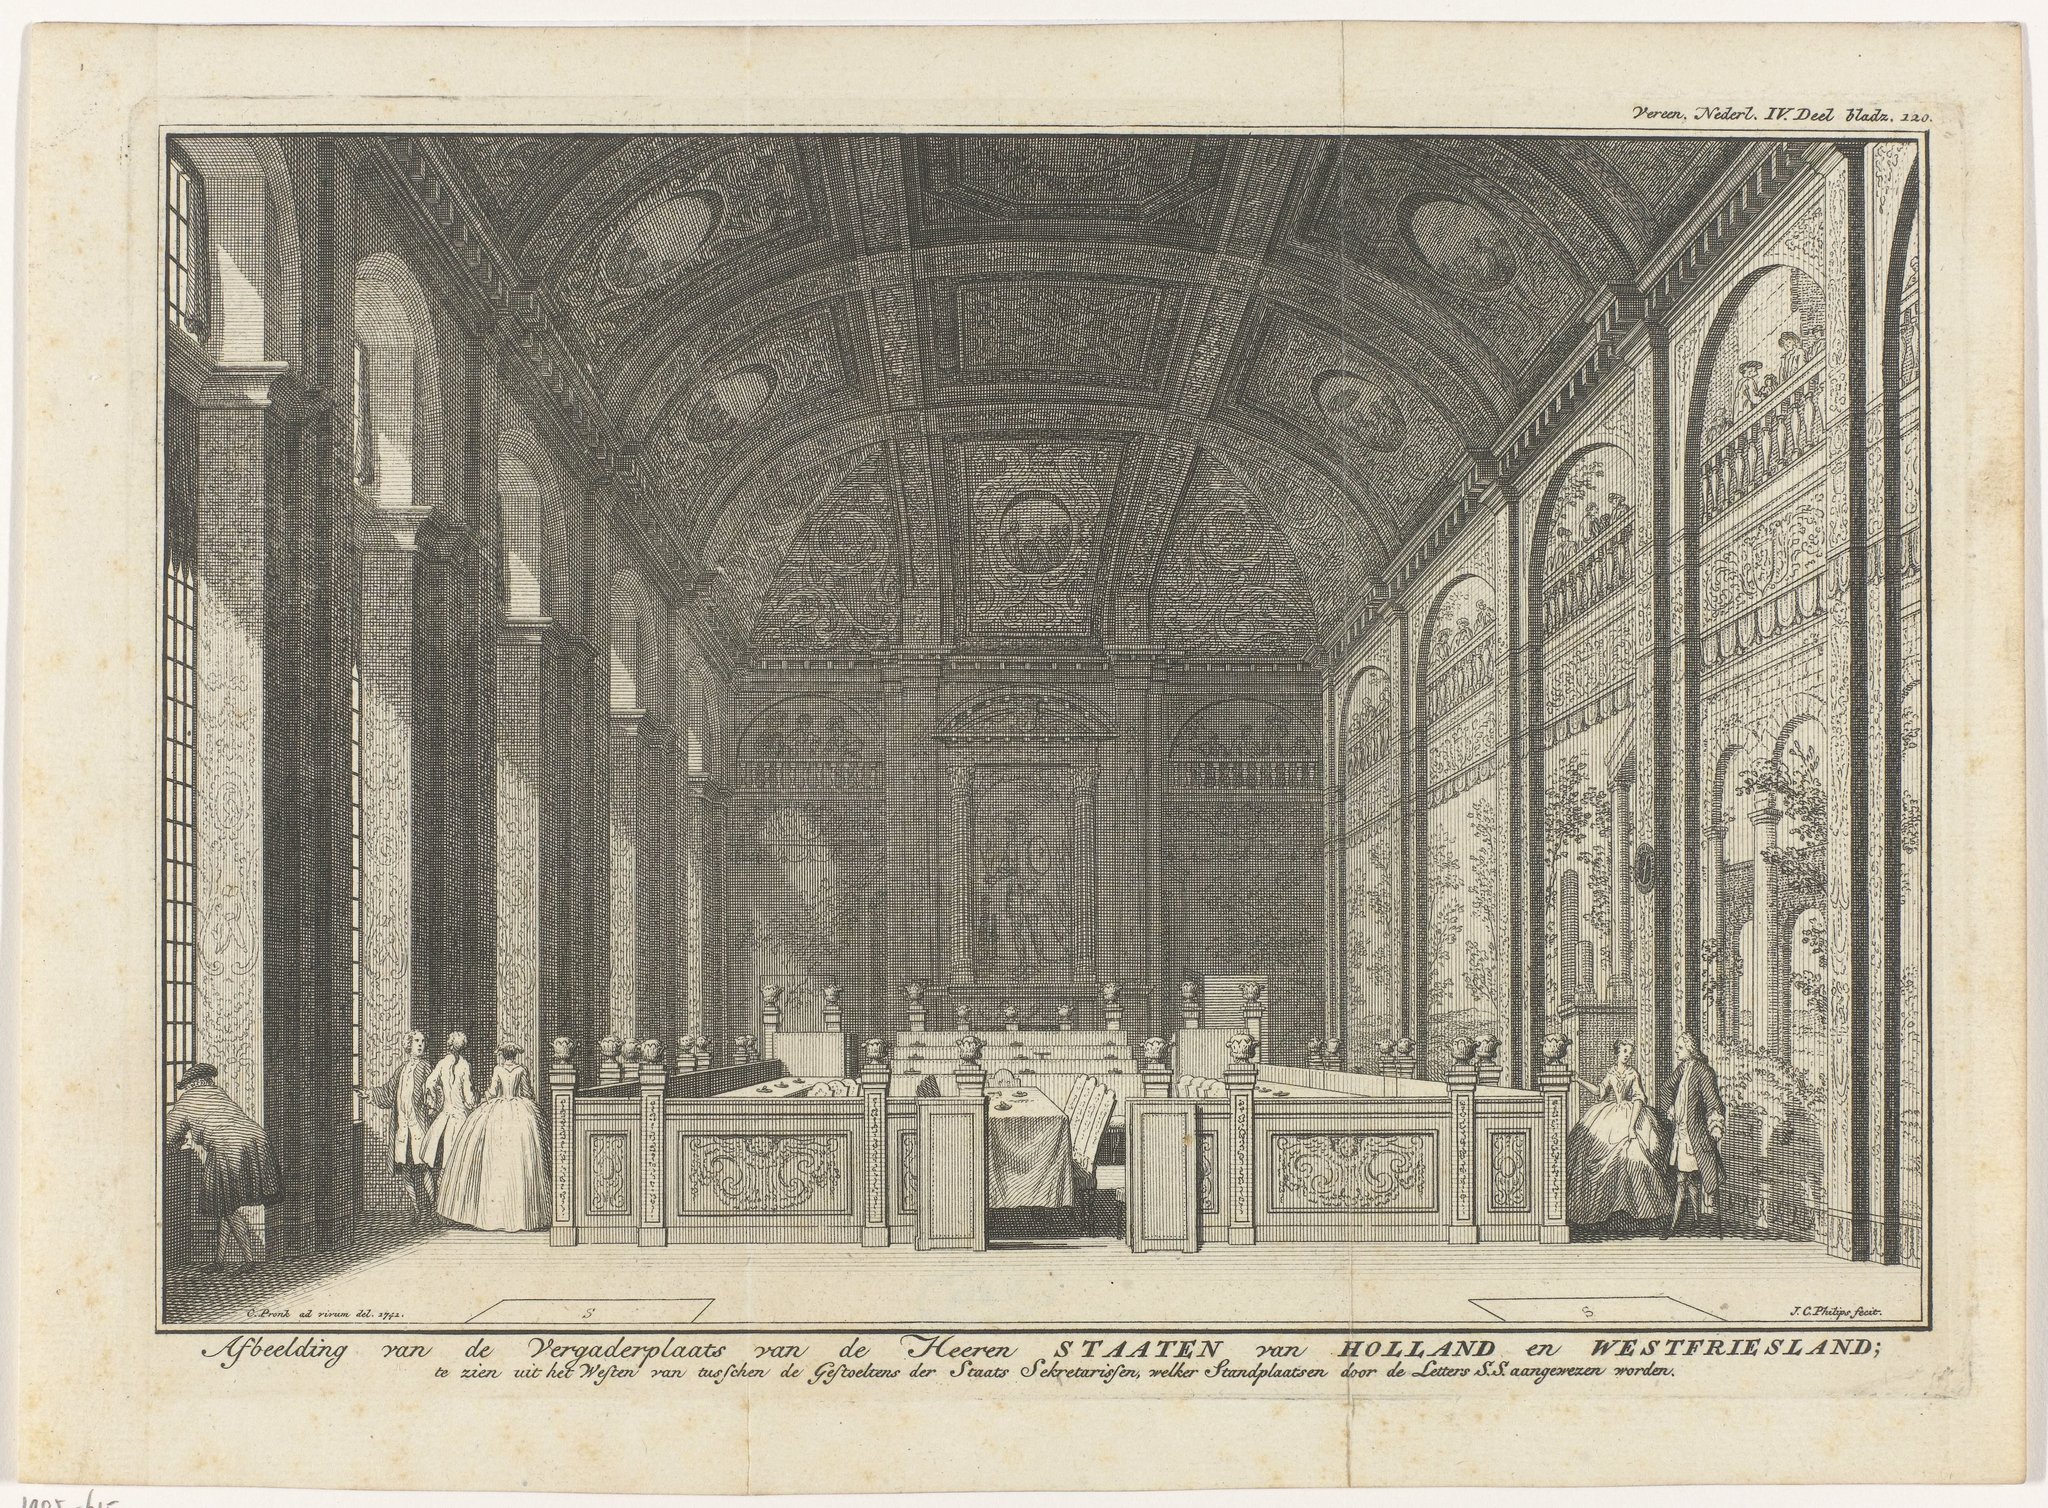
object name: print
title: Afbeelding van de vergaderplaats van de Heeren Staaten van Holland en Westfriesland; te zien uit het westen van tusschen de gestoeltens der staats sekretarissen, welker standplaatsen door de letters S.S. aangewezen worden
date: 1741-1742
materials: paper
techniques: engraving, etching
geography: amsterdam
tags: national government, lower house, parliament, chamber, the hague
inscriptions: collector's mark: Lugt 2228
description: De vergaderzaal van de Staten van Holland en West-Friesland in het Hof te Den Haag, 1741.